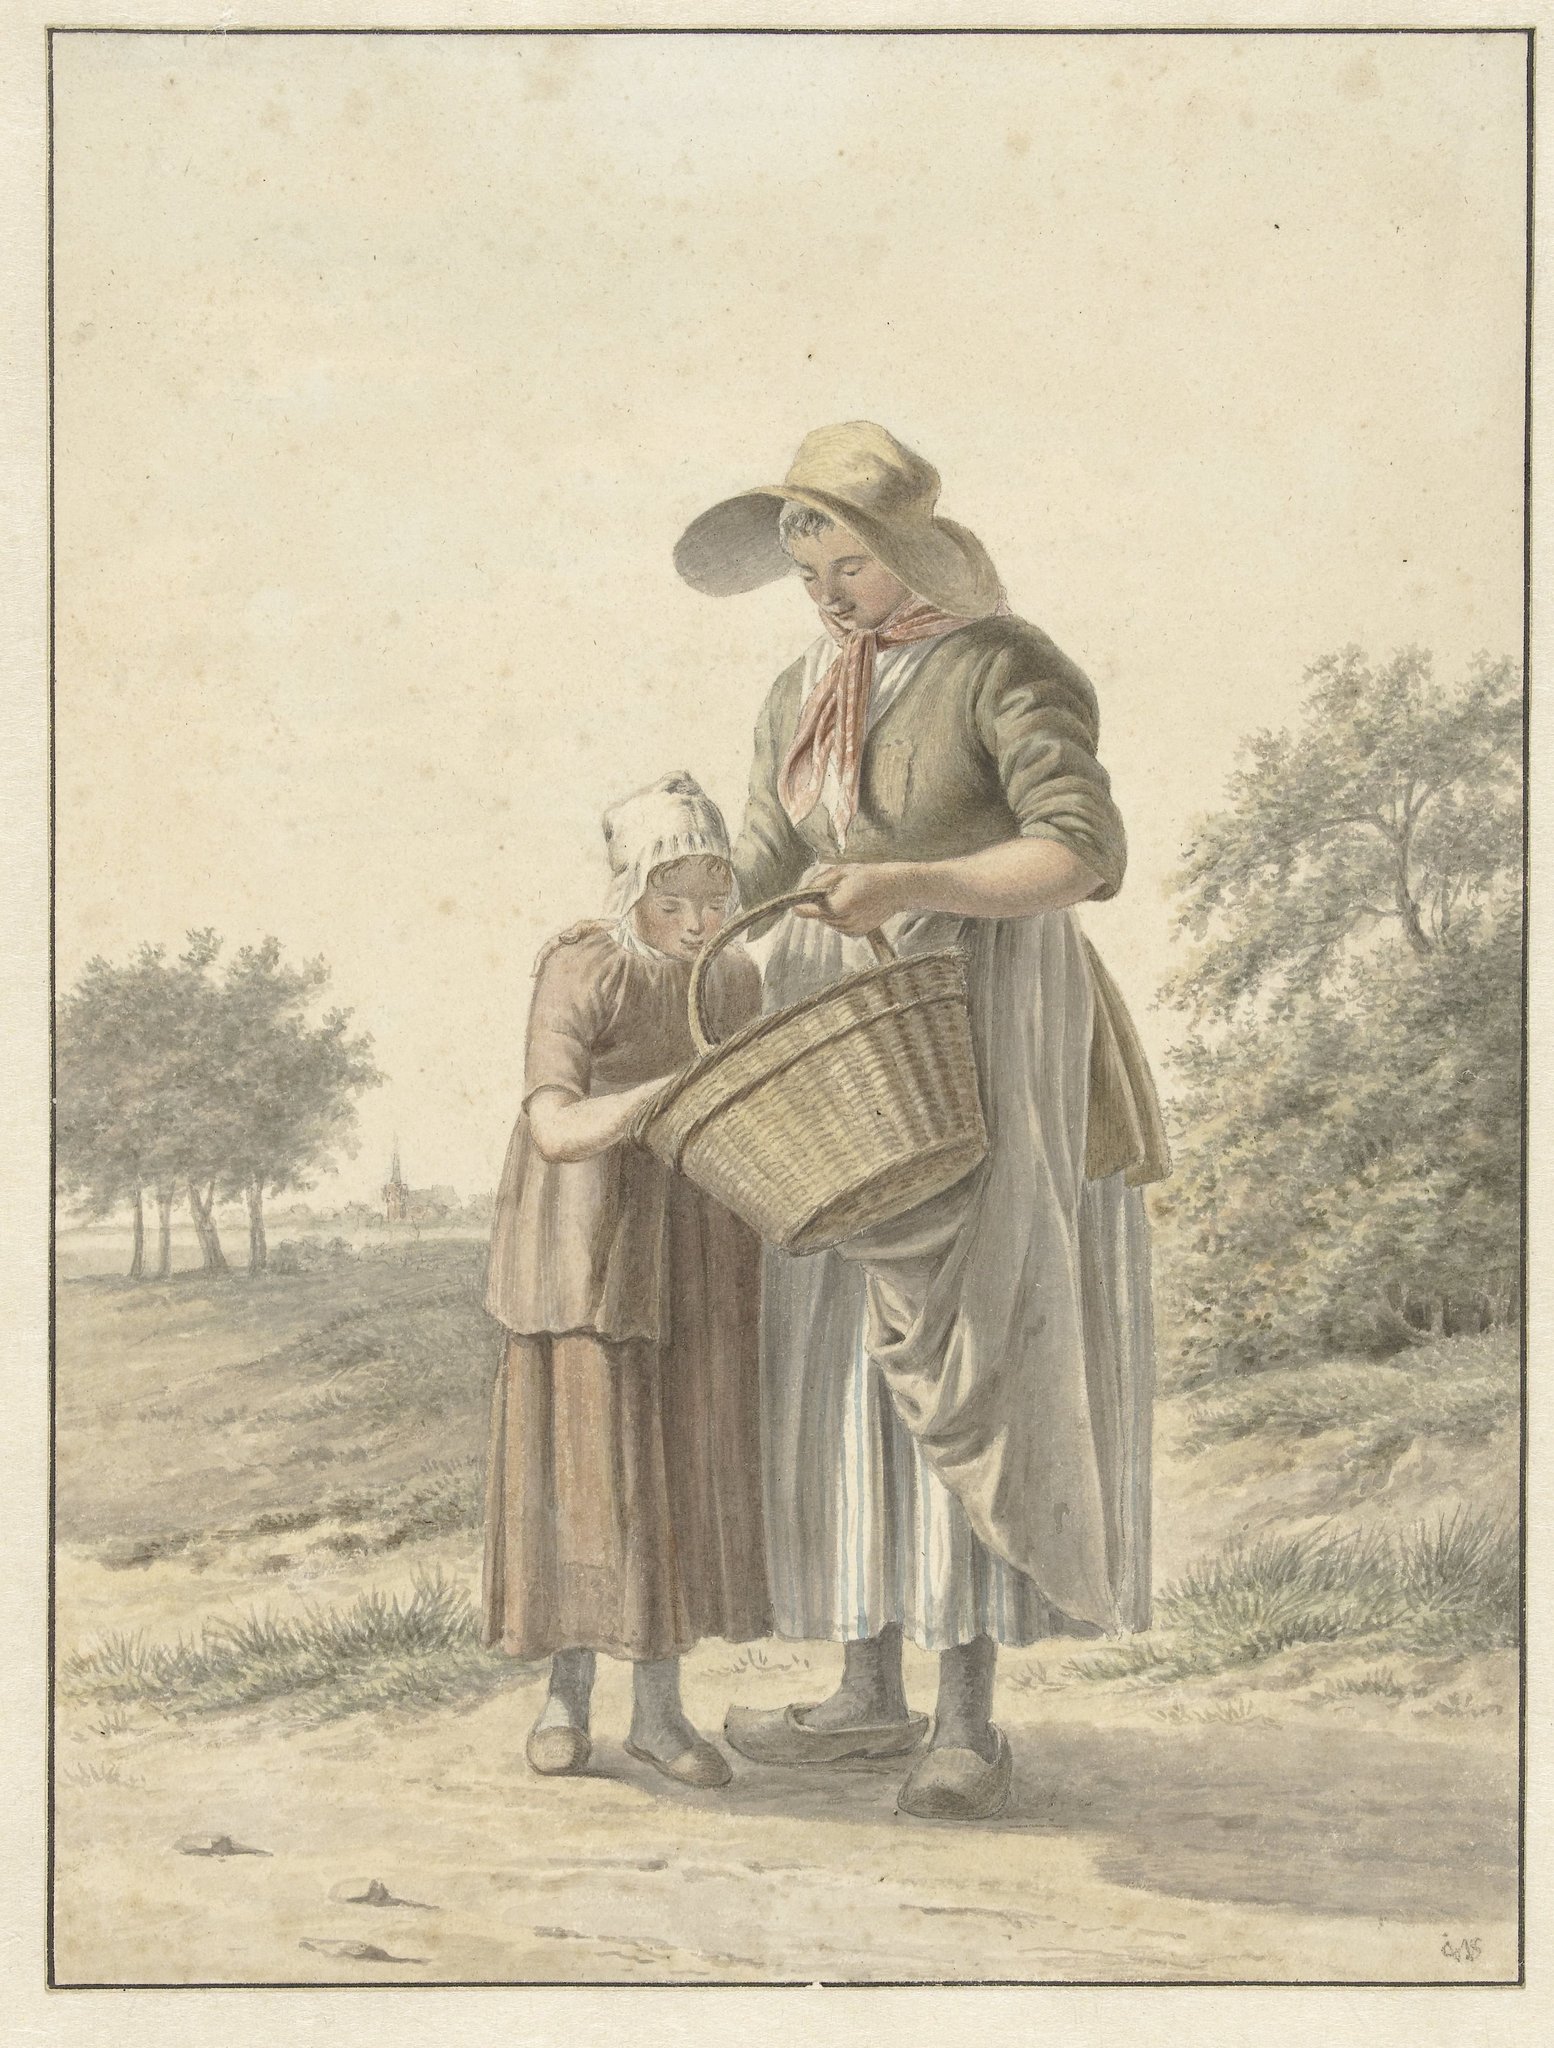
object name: drawing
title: Vrouw en meisje op een landweg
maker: johan christiaan willem safft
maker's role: draughtsman, print maker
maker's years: 1778-1849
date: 1788-1849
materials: paper, watercolor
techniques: brush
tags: folk costume, regional costume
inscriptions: monogram: ‘JCWS’